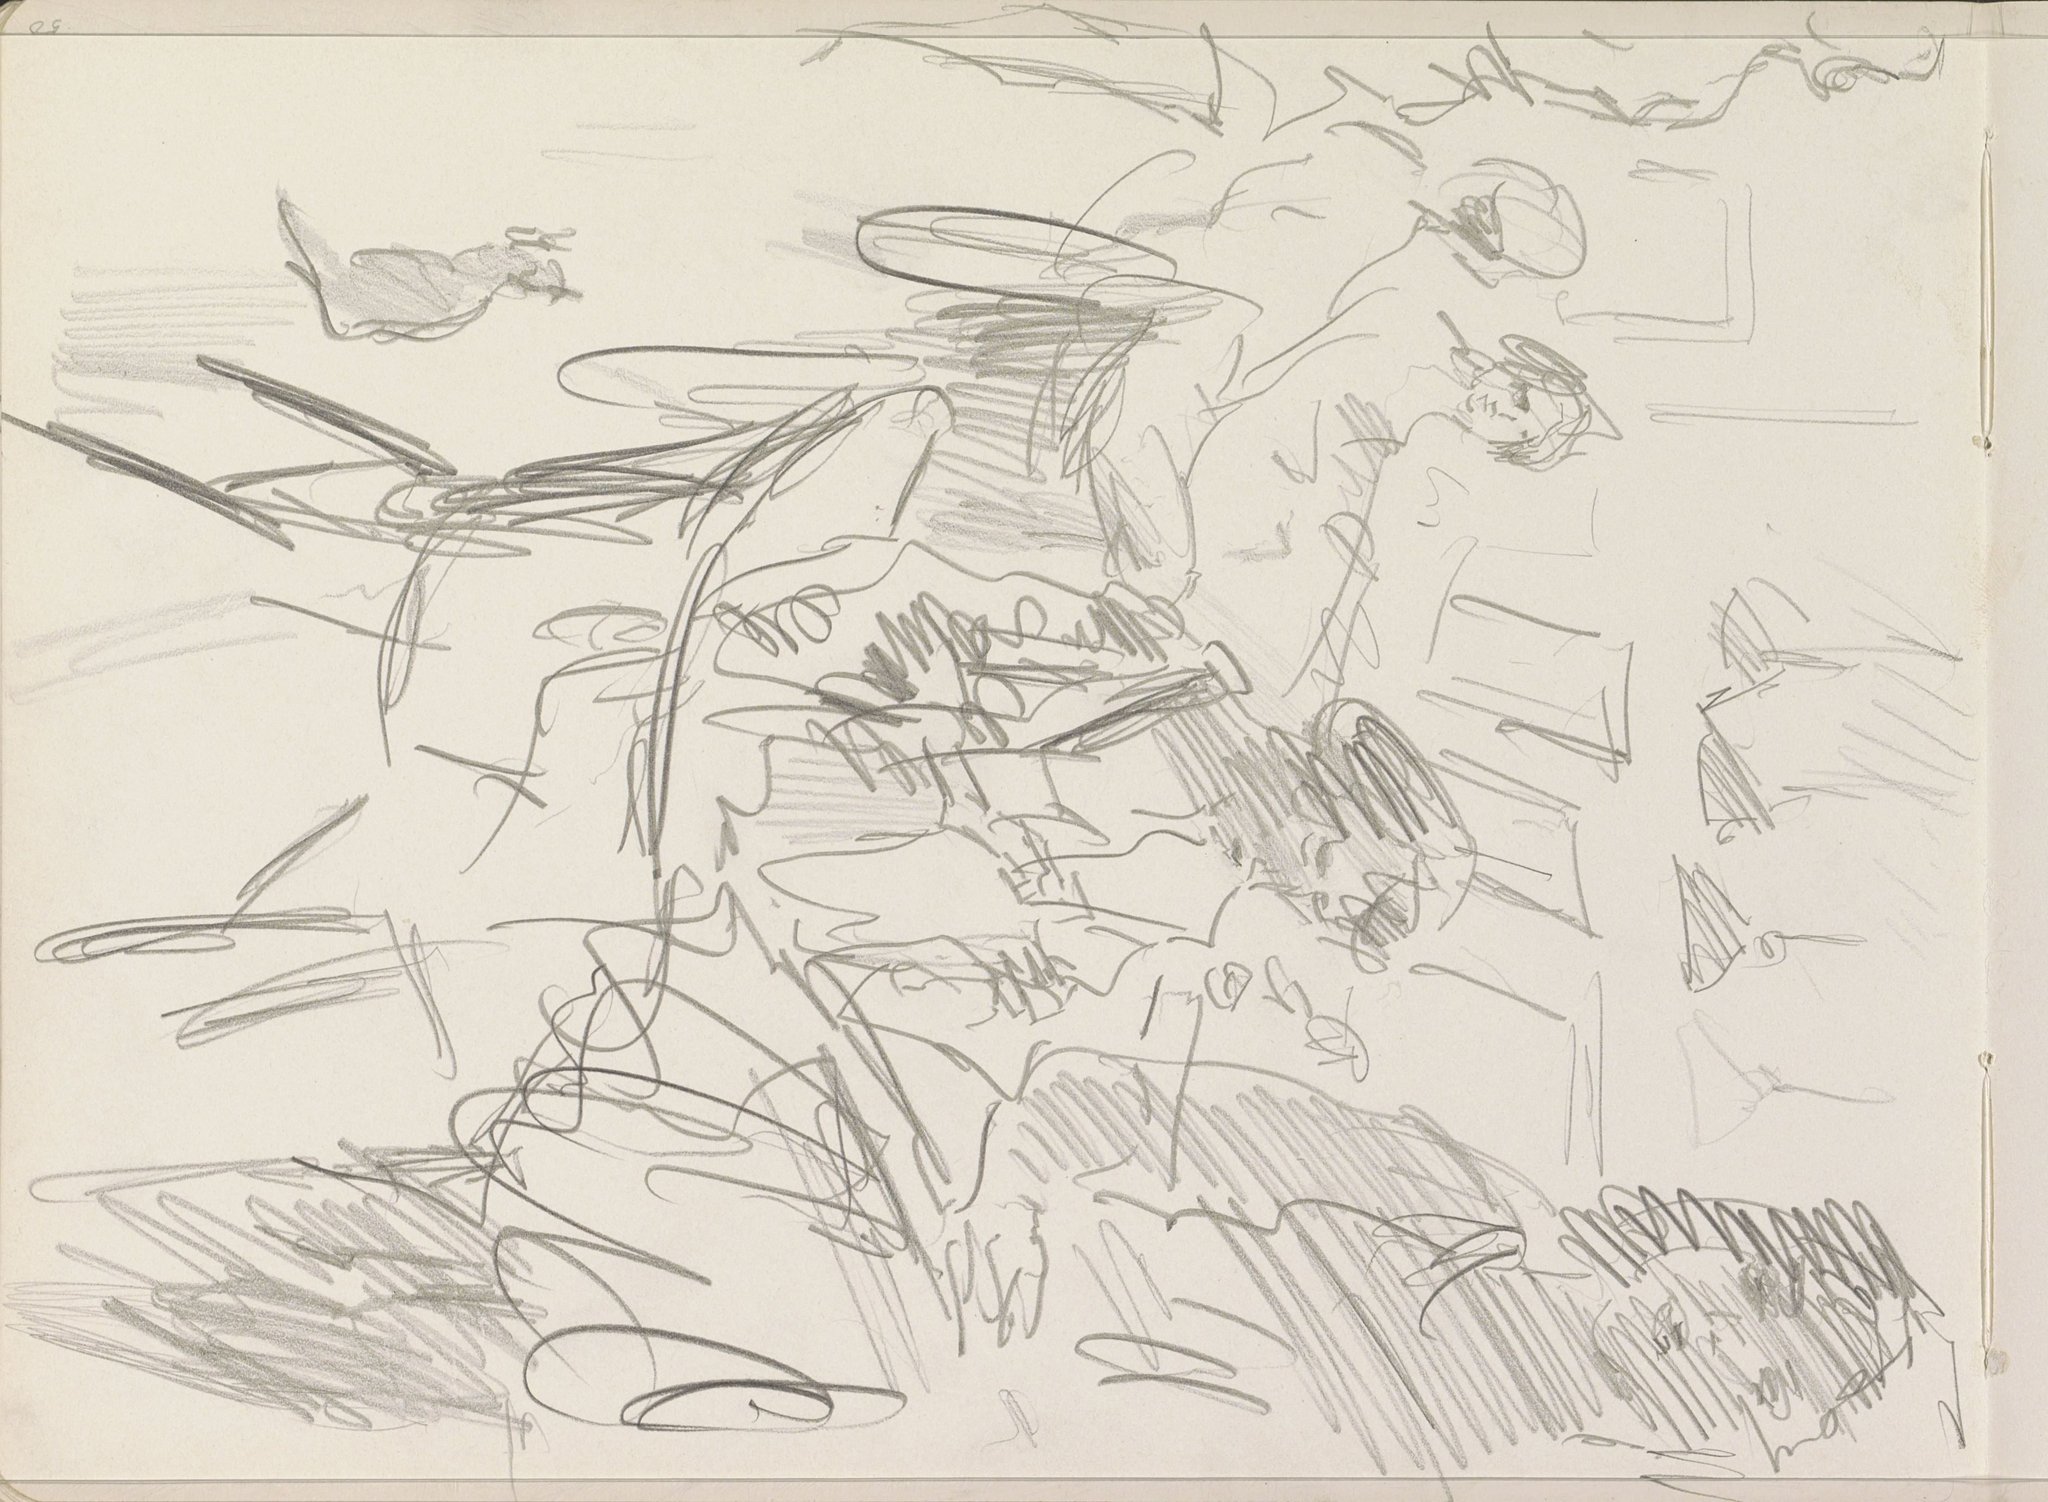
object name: sketchbook leaf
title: Vrouwen in een kleedkamer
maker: isaac israels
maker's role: draughtsman, painter, print maker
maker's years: 1865-1934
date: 1915-1934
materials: paper, pencil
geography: the hague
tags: adult woman (+ five persons), dressing-room ~ stage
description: Mogelijk in Theater Scala te Den Haag. Blad 23 verso uit schetsboek III met 36 bladen.